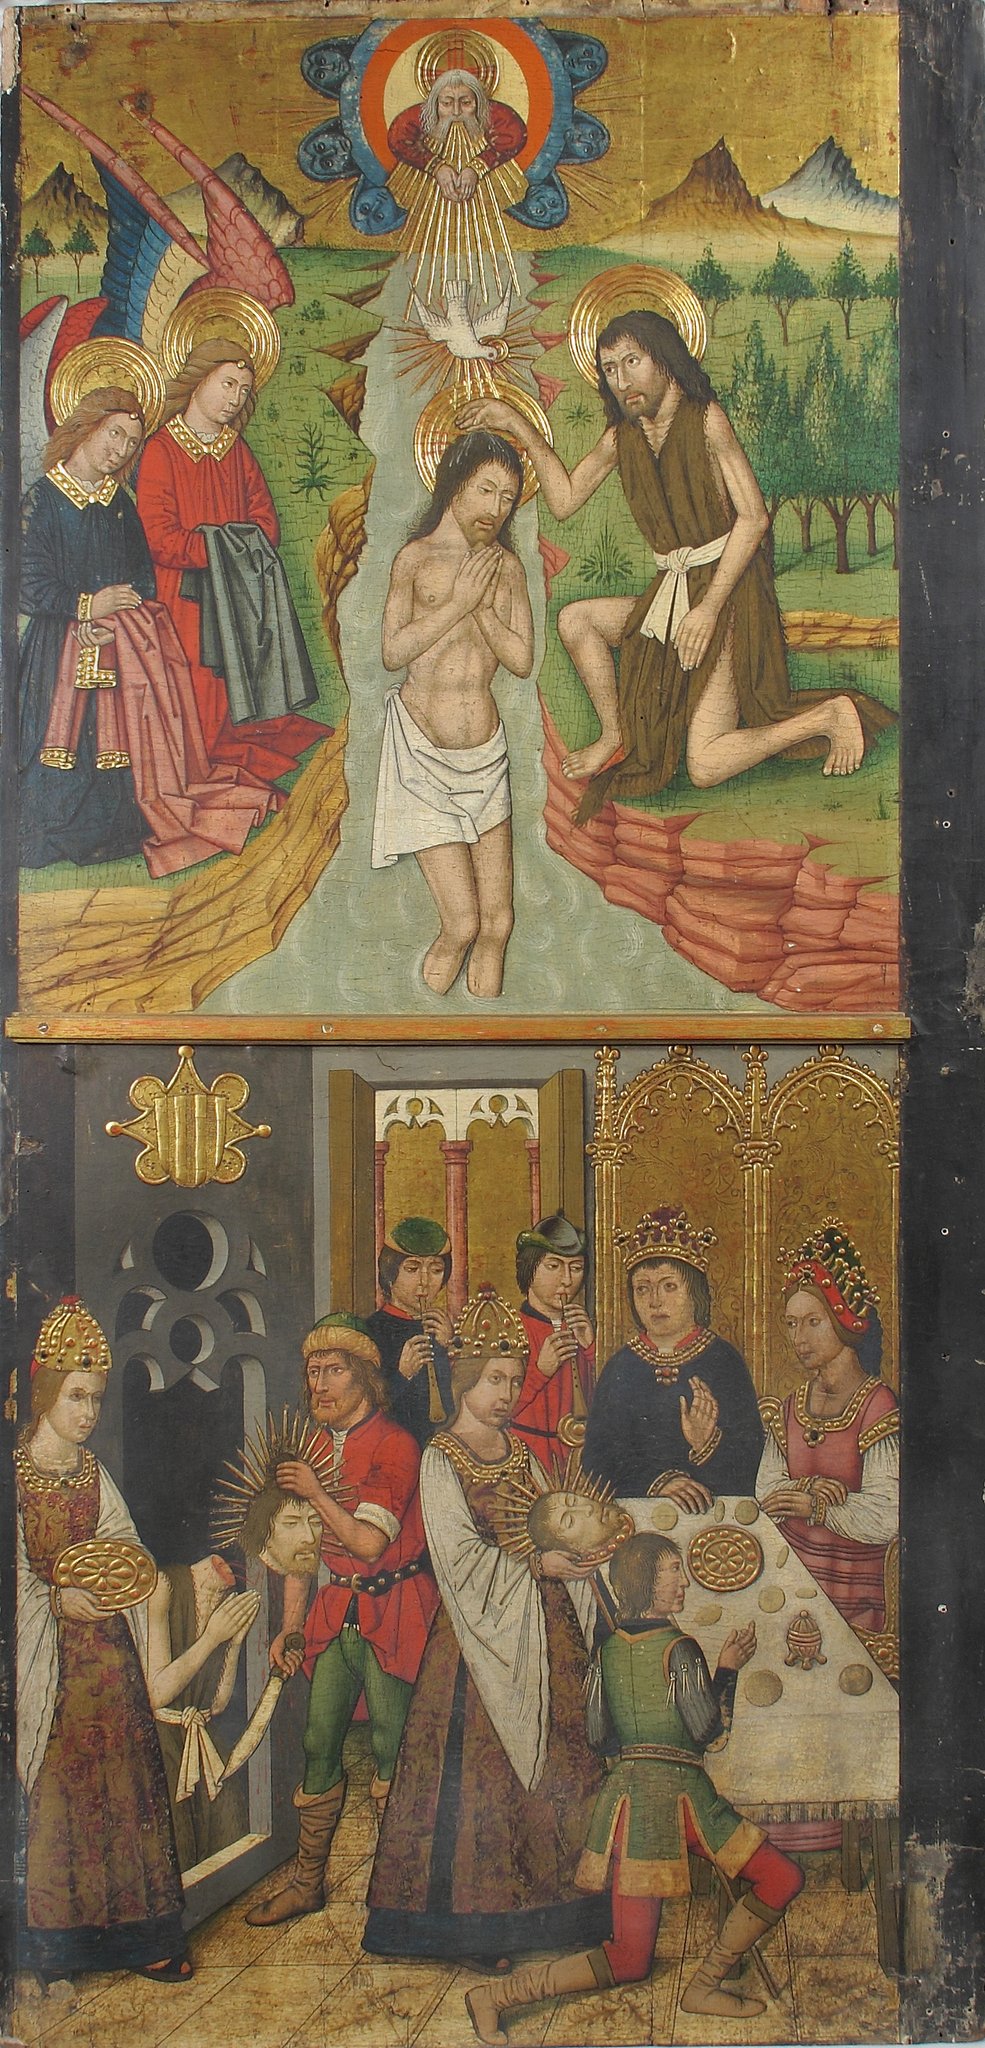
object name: painting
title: Panel from Saint John Retable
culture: spanish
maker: domingo ram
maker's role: artist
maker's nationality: spanish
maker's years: 1464-1507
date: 1464-1507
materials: gold leaf, paint, wood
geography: spain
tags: men,women,angels,christ,saint john the baptist,banquets